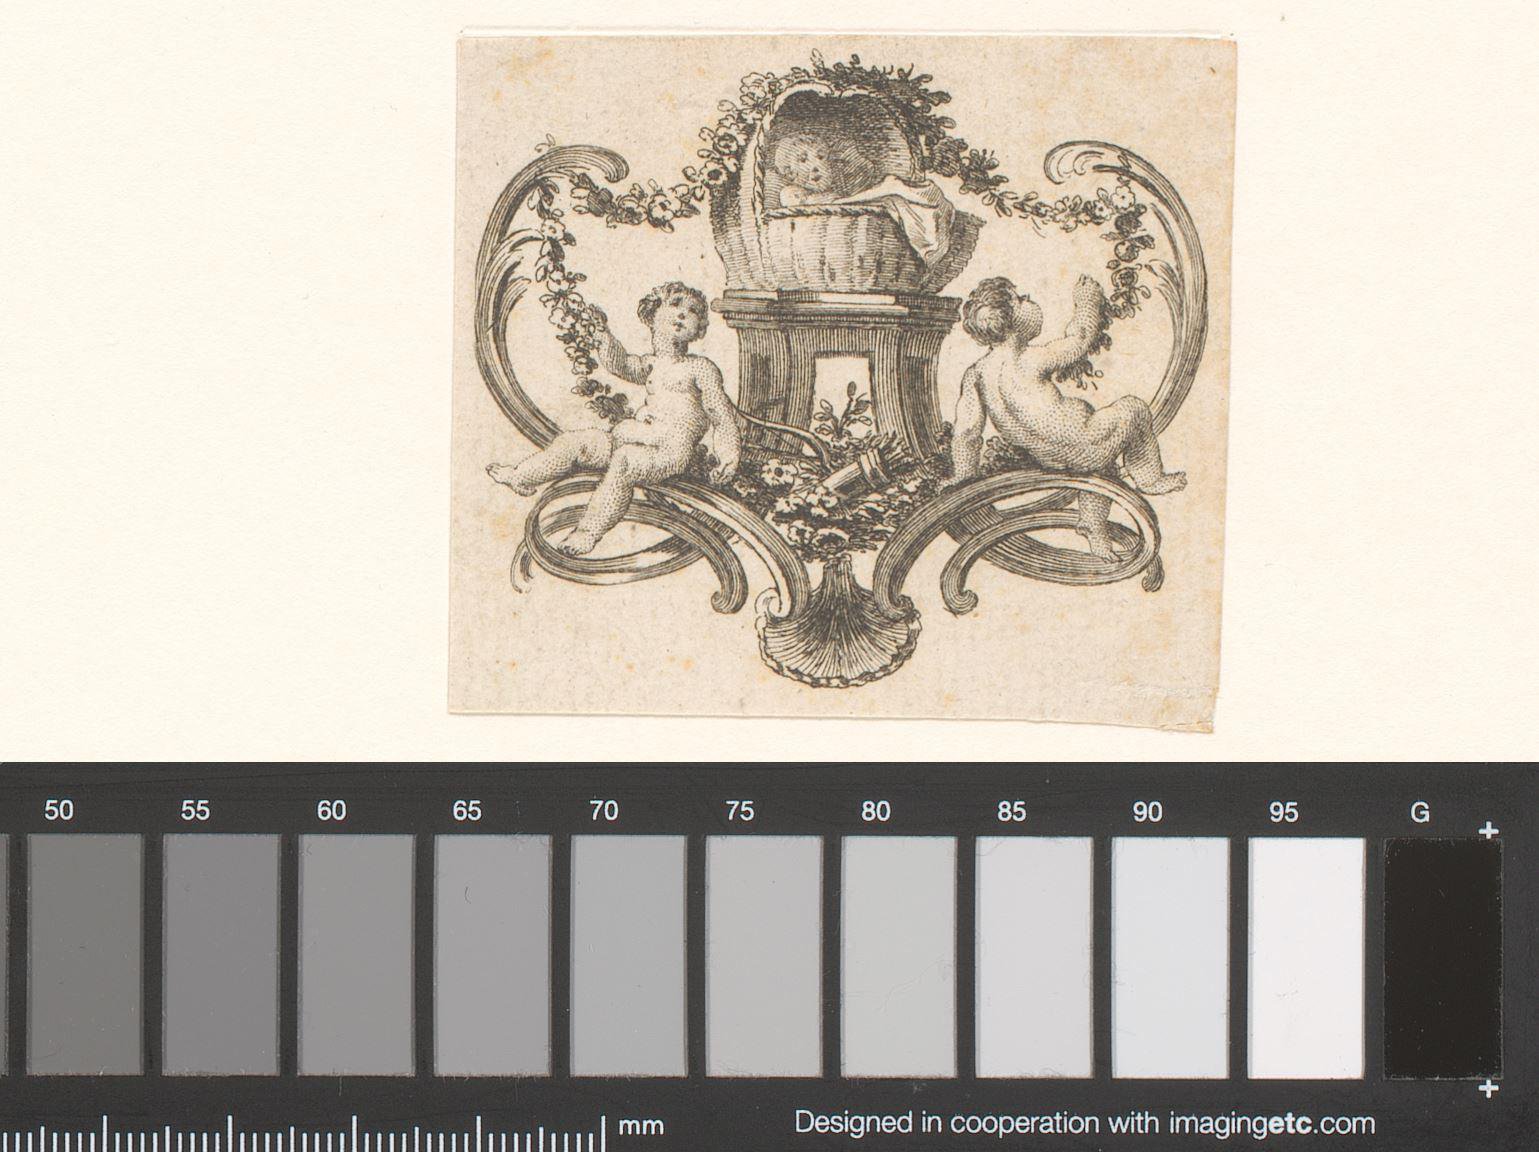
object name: print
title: Vignet met drie kinderen waarvan één in een wieg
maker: Anonymous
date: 1700-1800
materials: paper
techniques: etching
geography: northern netherlands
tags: archer's weapons: bow and arrow, cradle, crib, ornament ~ festoon, garland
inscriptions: collector's mark: Lugt 2228, collector's mark: Lugt 2760